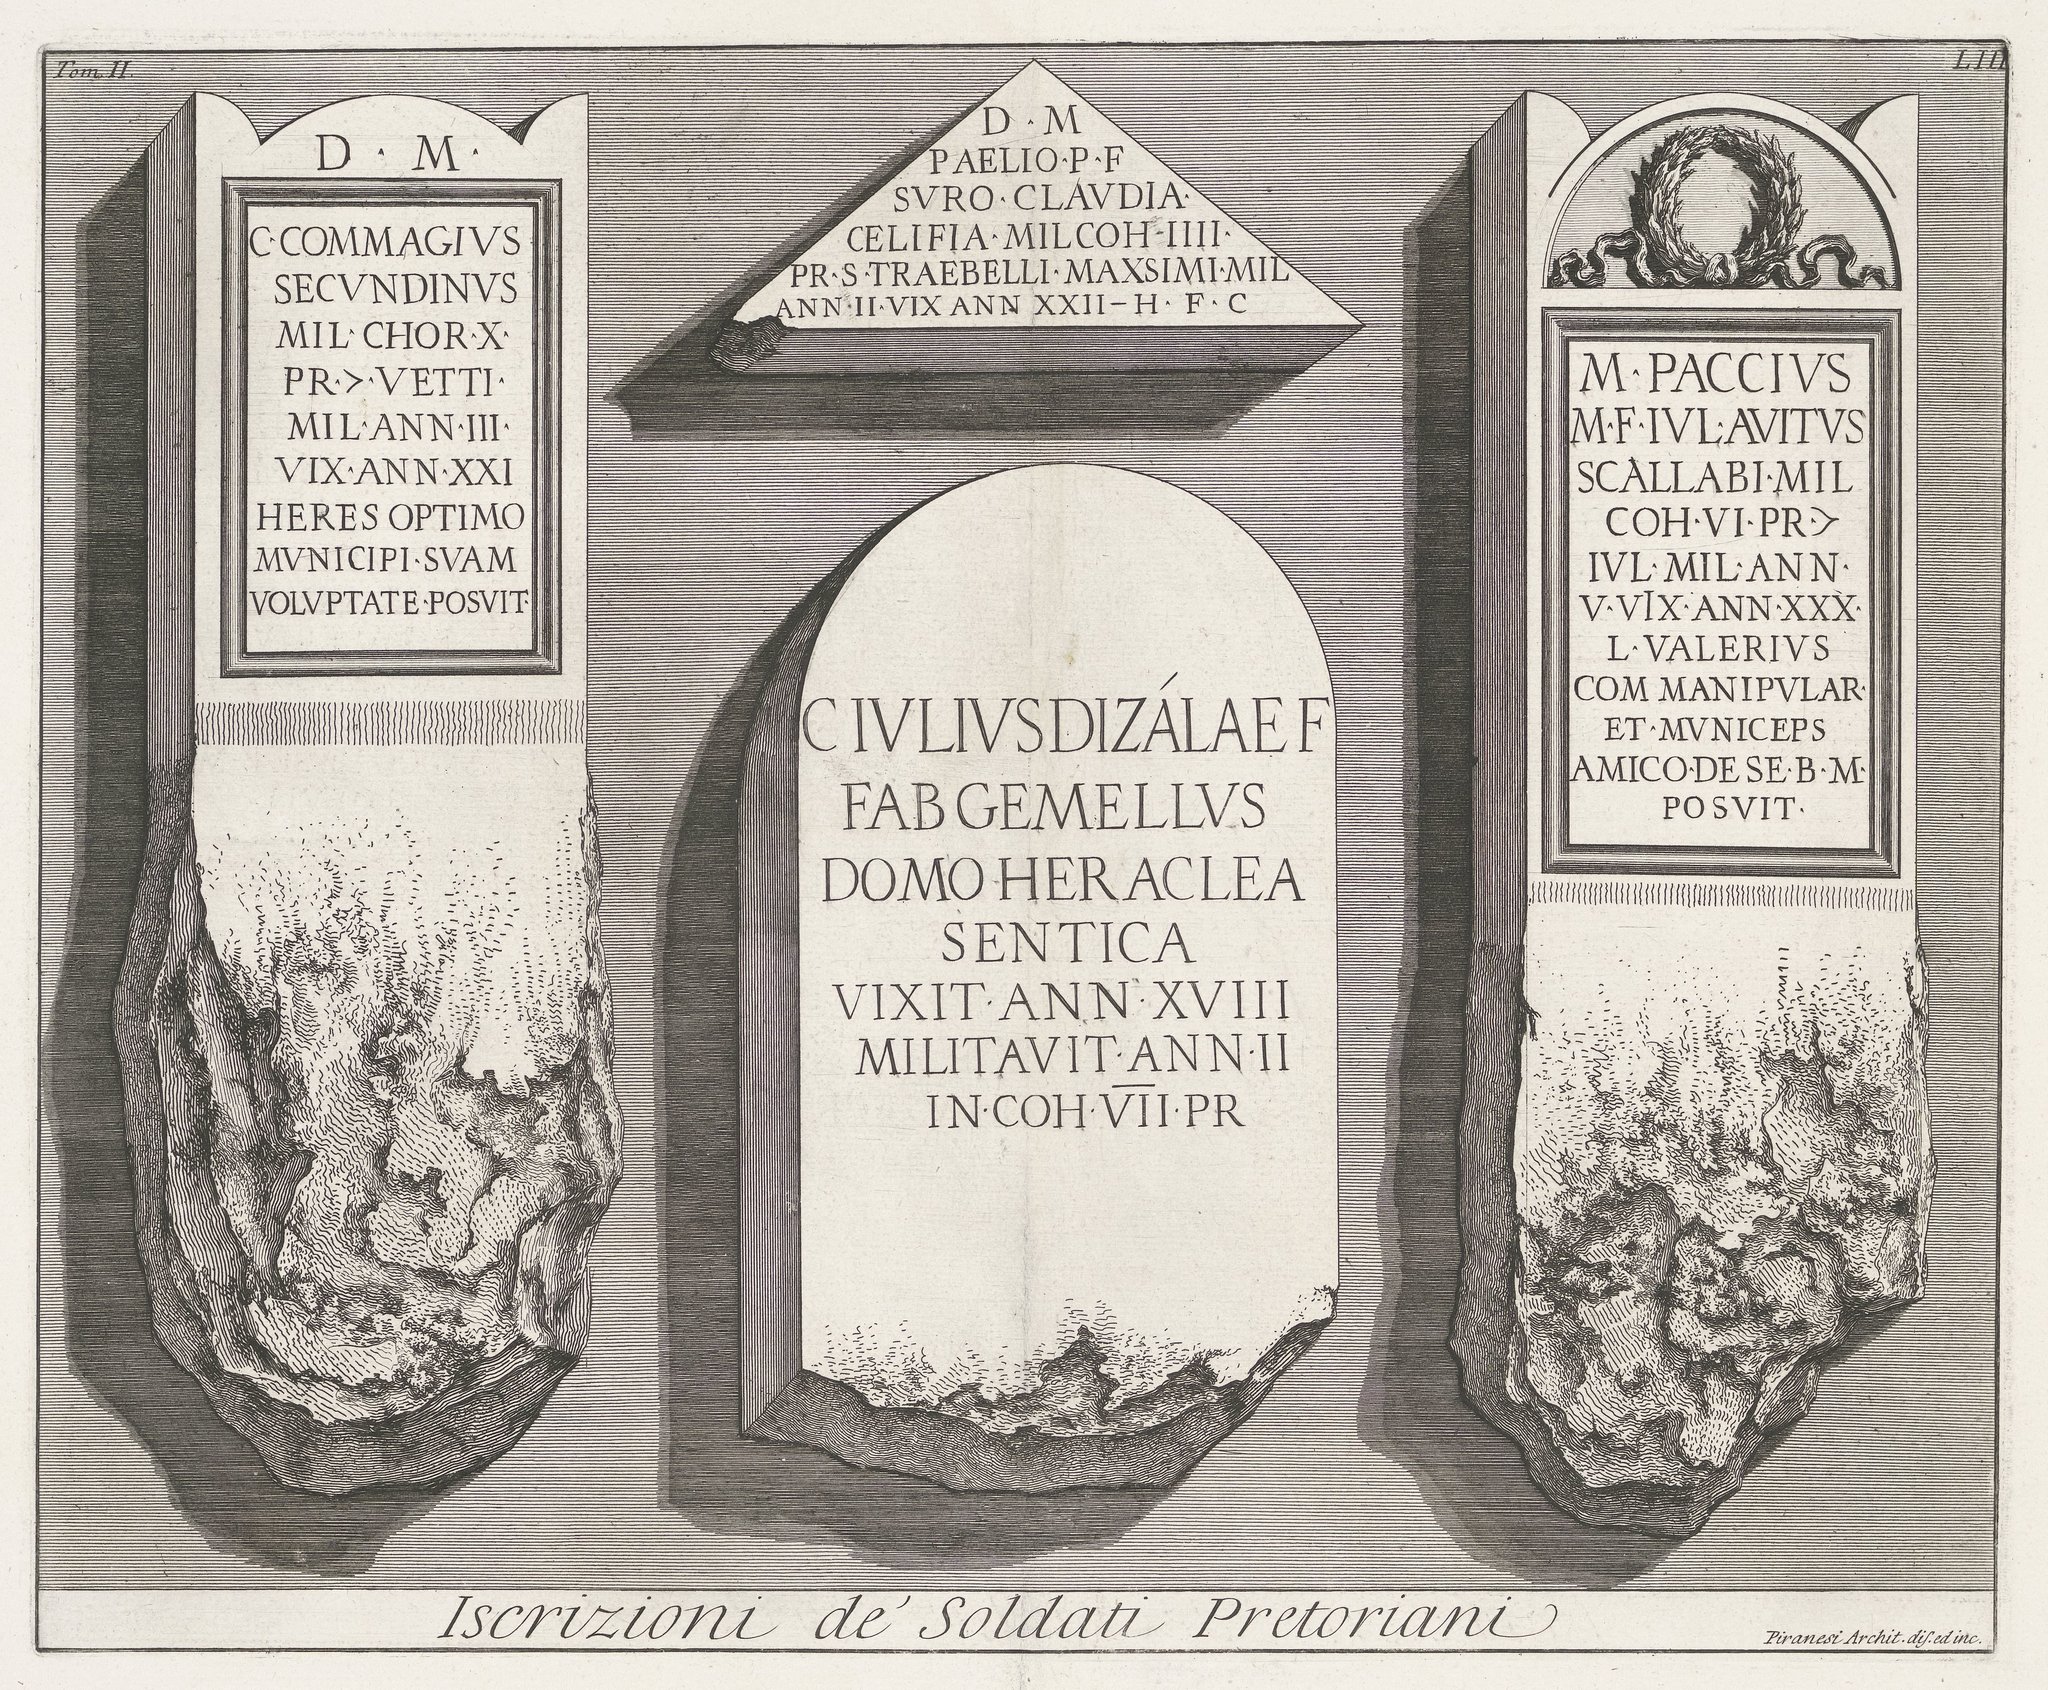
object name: print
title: Le Antichità Romane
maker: giovanni battista piranesi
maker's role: designer, draughtsman, print maker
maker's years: 1720-1778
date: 1756-1757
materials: paper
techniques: etching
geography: rome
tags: inscription, italy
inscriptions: collector's mark: Lugt 2228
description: Deze prent maakt deel uit van de serie 'Le Antichità Romane'. Piranesi deed meer dan acht jaar voorstudie voor deze 250 platen tellende serie die in vier volumes werd uitgegeven. Hij produceerde de prenten tussen ca. 1756 en 1757. De serie bevat ook prenten door of naar andere prentmakers, onder wie Francesco Bianchini en Girolamo Rossi.